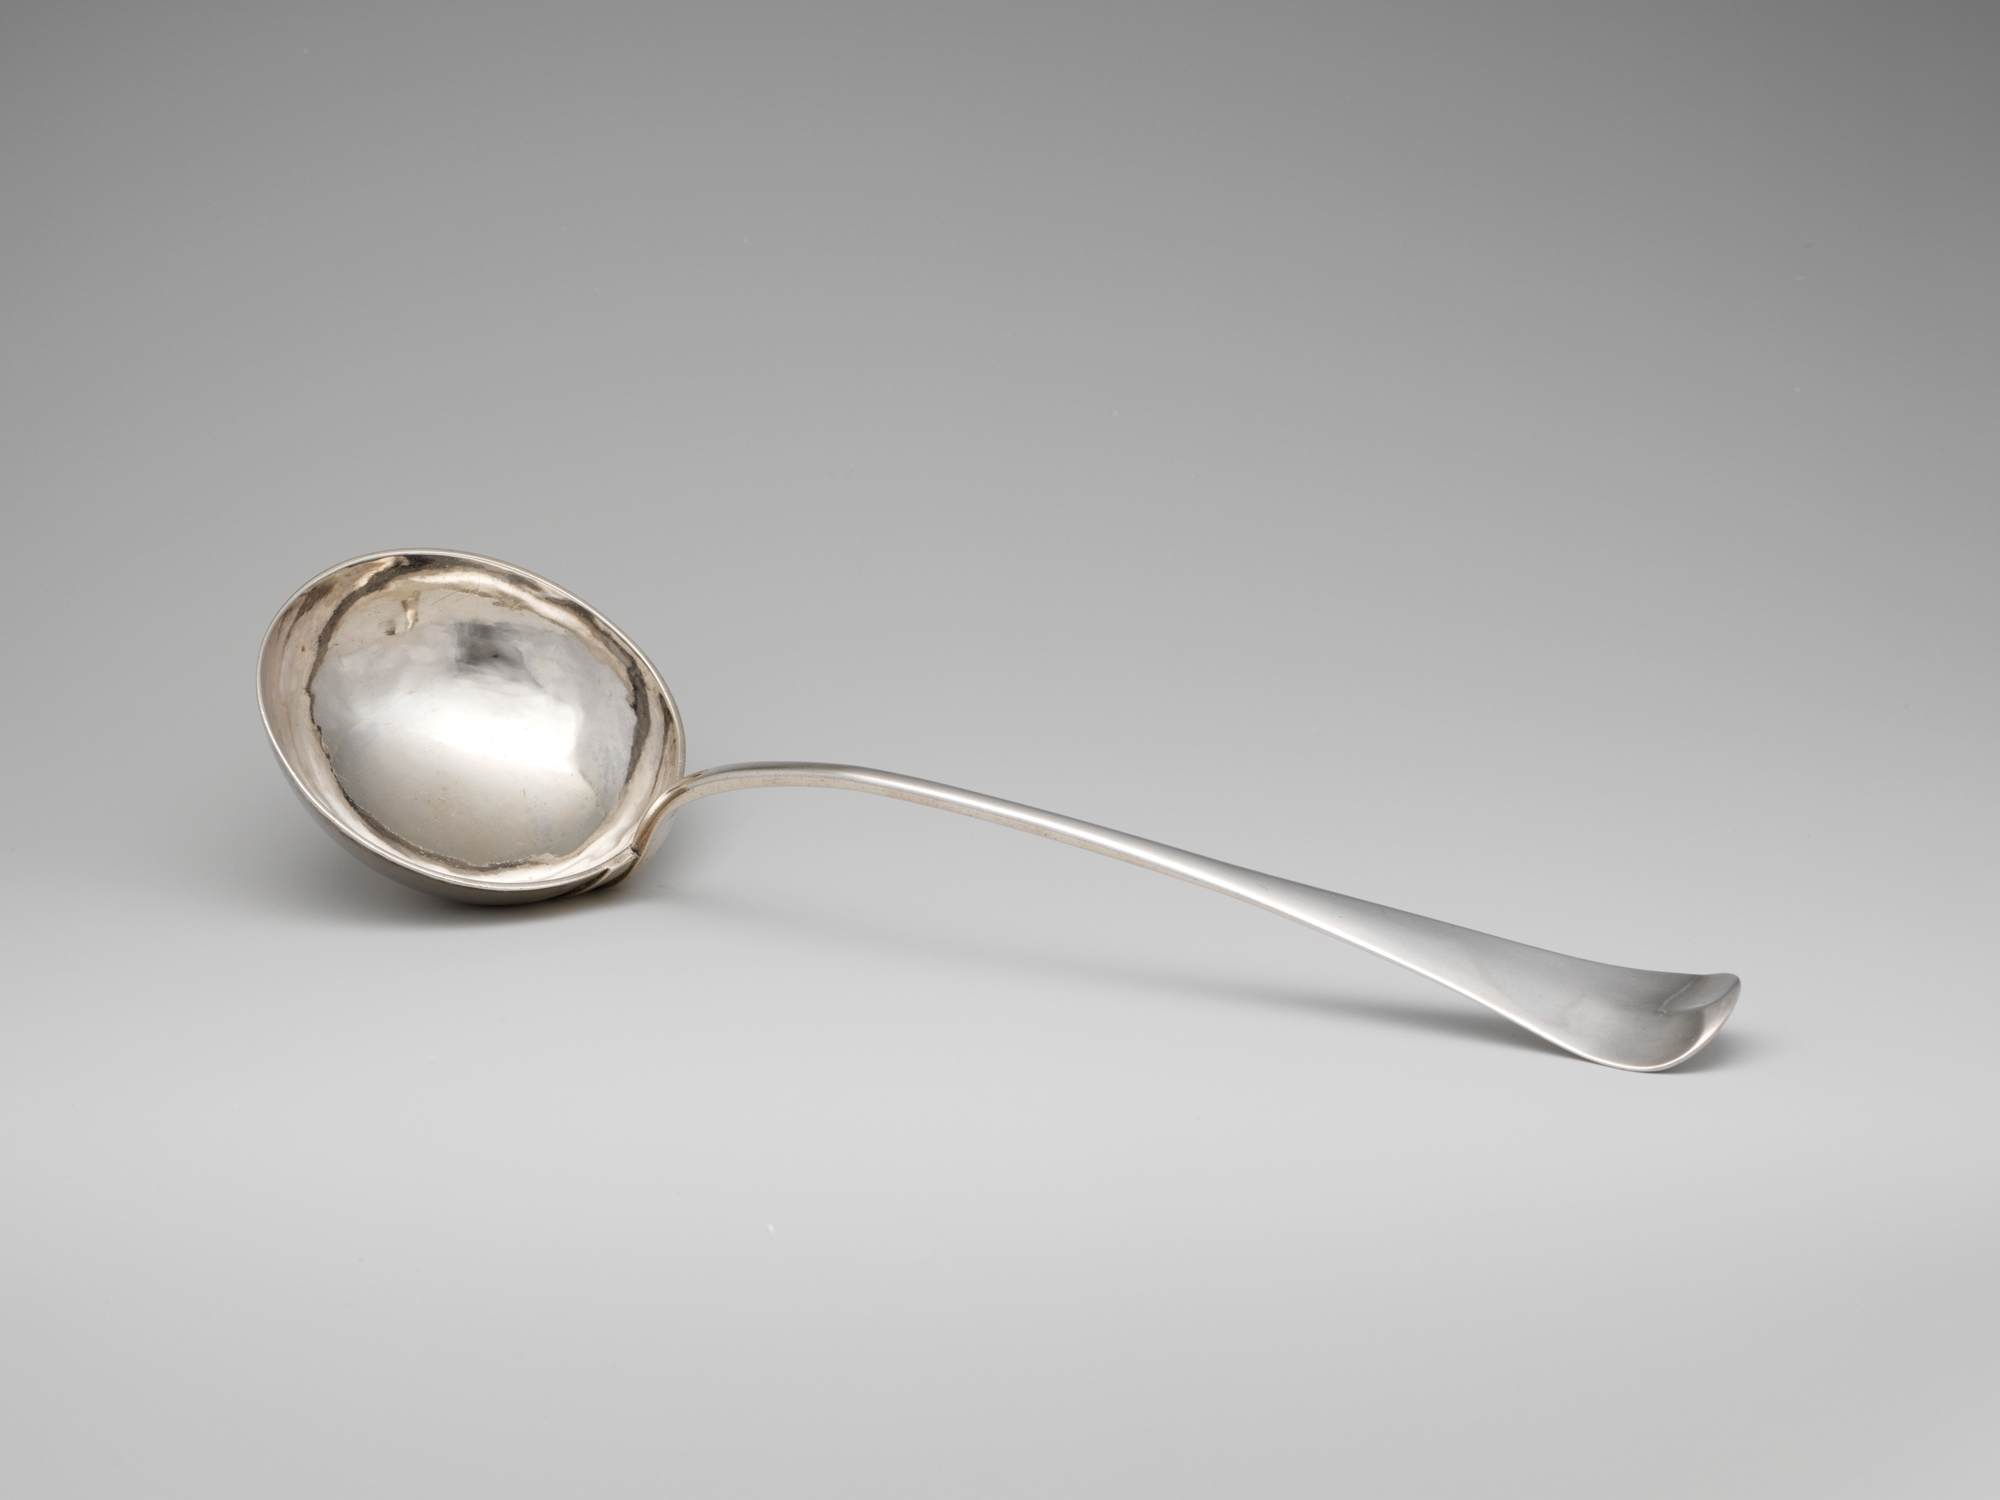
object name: ladle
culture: american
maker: john burt lyng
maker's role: maker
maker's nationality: american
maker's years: 1758-1785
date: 1750-1775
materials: silver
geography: united states